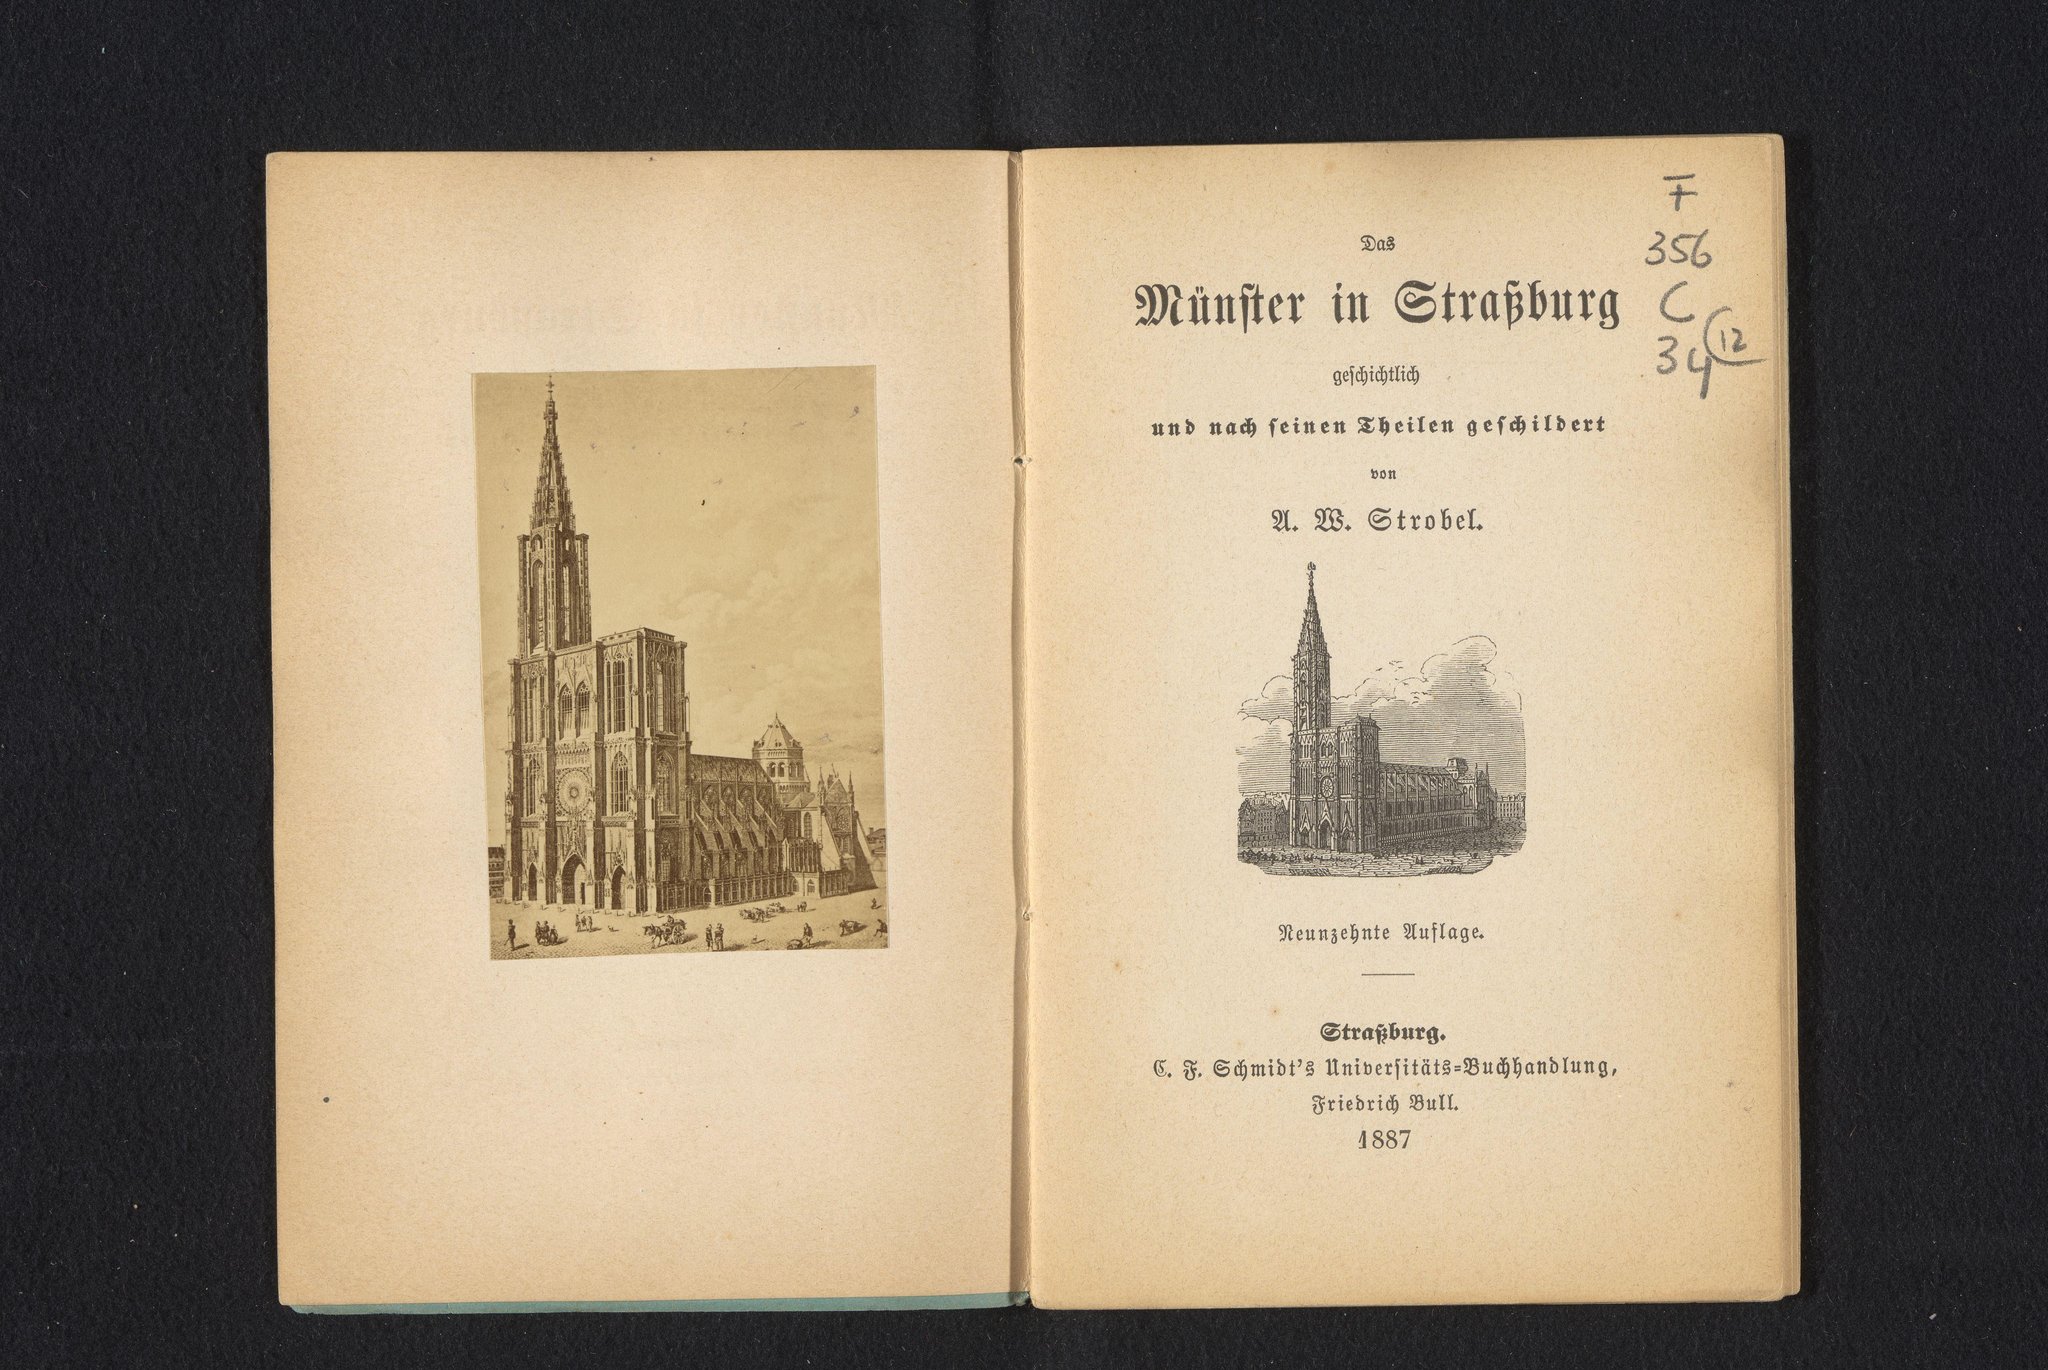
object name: page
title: Fotoreproductie van een gezicht op de Kathedraal van Straatsburg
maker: Anonymous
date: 1882-1887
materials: photographic support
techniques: albumen print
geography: straatsburg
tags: church (exterior)